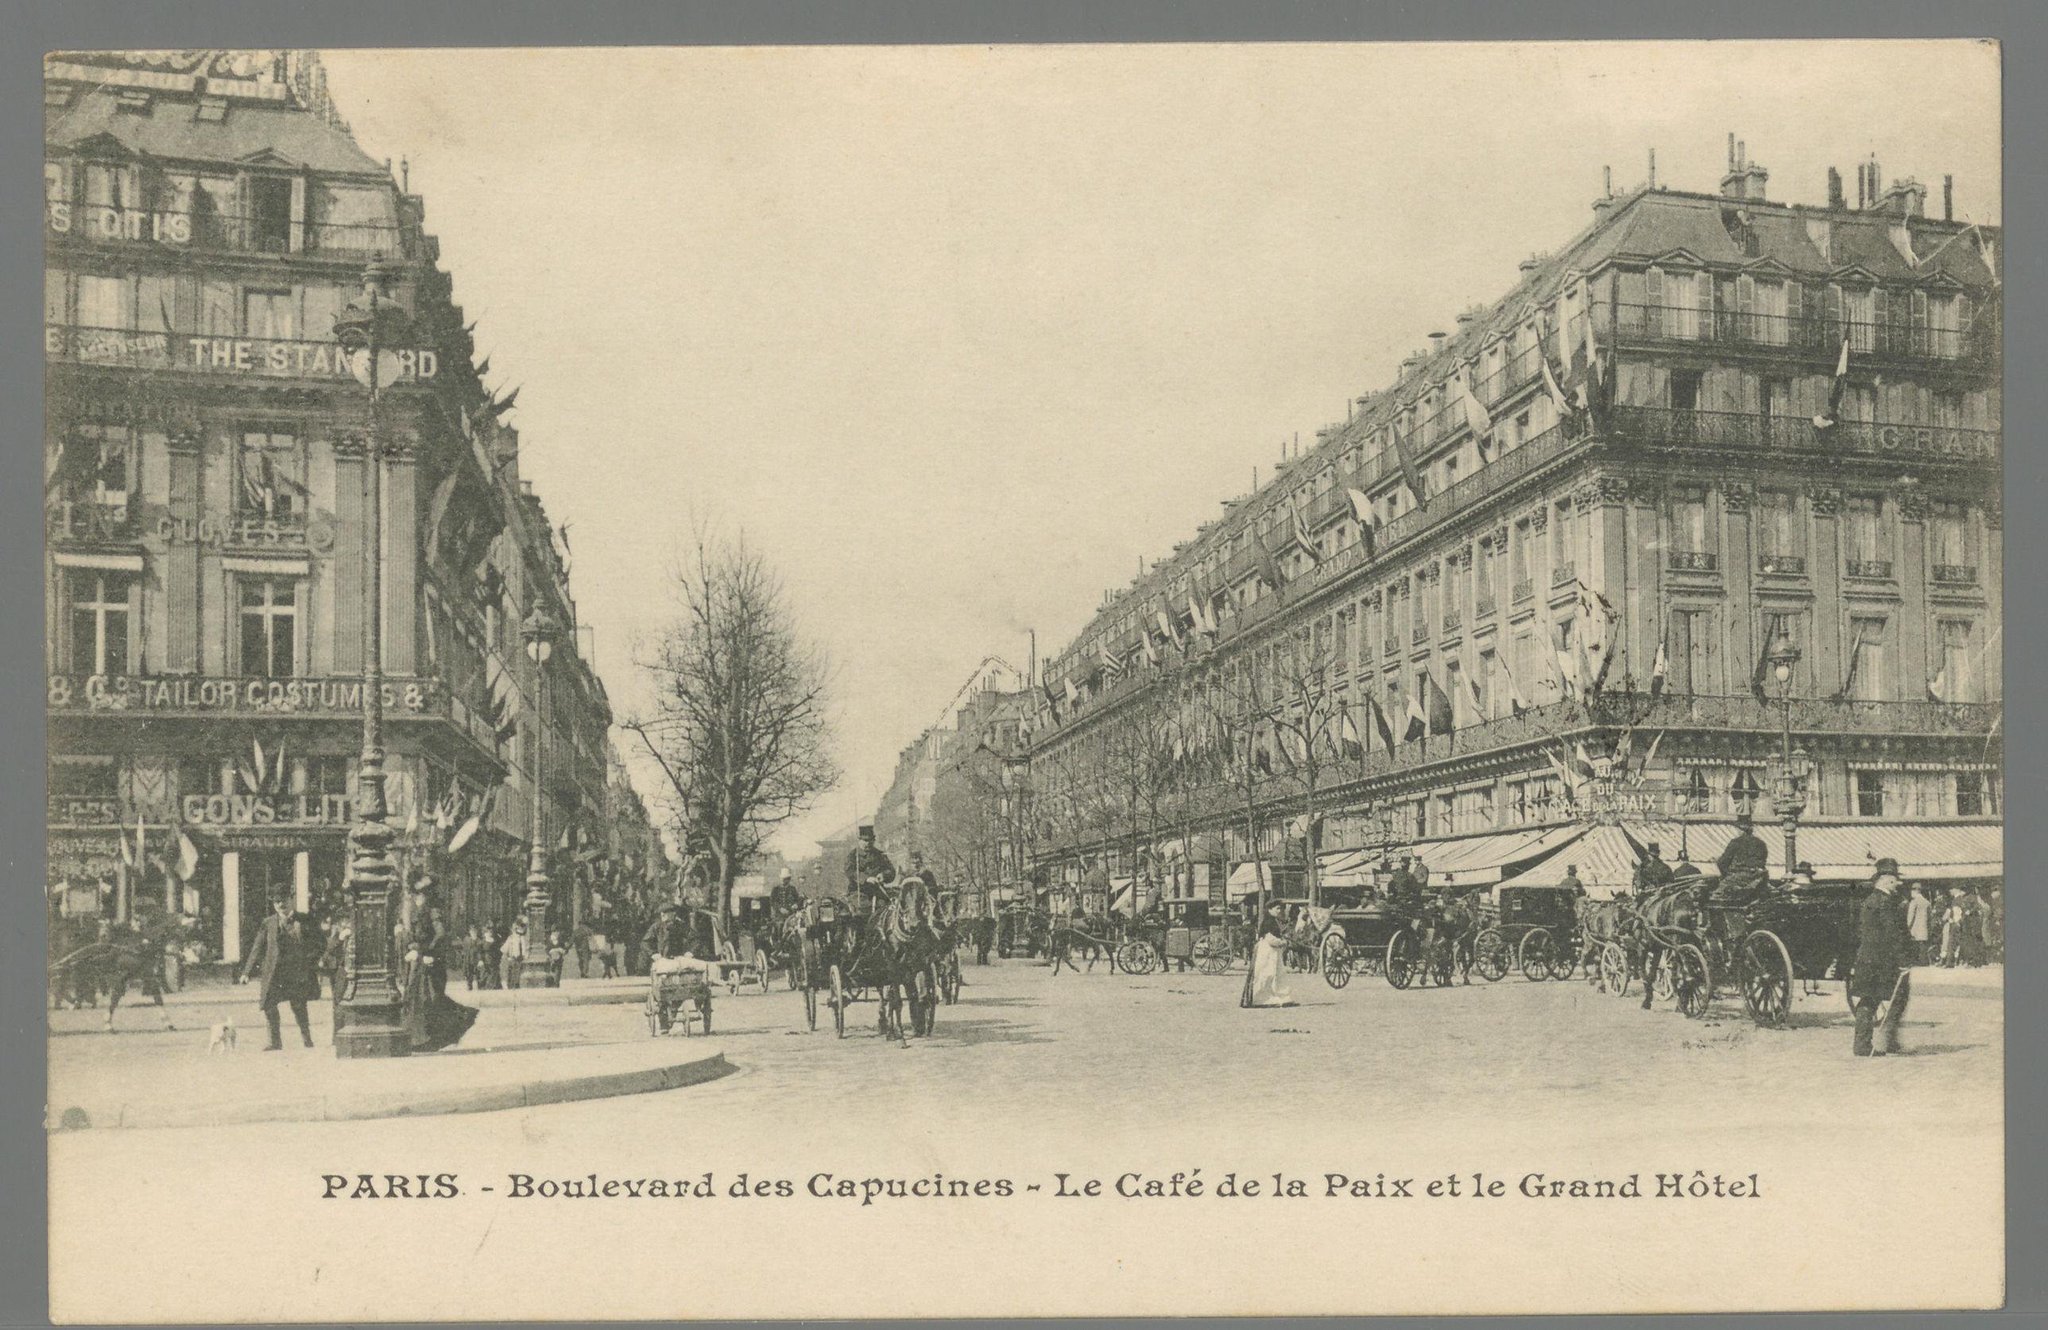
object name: photomechanical print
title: Paris. Boulevard des Capucines. Le Café de la Paix et le Grand Hôtel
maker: Anonymous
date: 1892-1902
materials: cardboard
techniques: photograph, writing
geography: paris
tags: avenue, boulevard, promenade, esplanade (+ city(-scape) with figures, staffage), four-wheeled, animal-drawn vehicle, e.g.: cab, carriage, coach, inn, coffee-house, public house, etc.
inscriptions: postage stamp